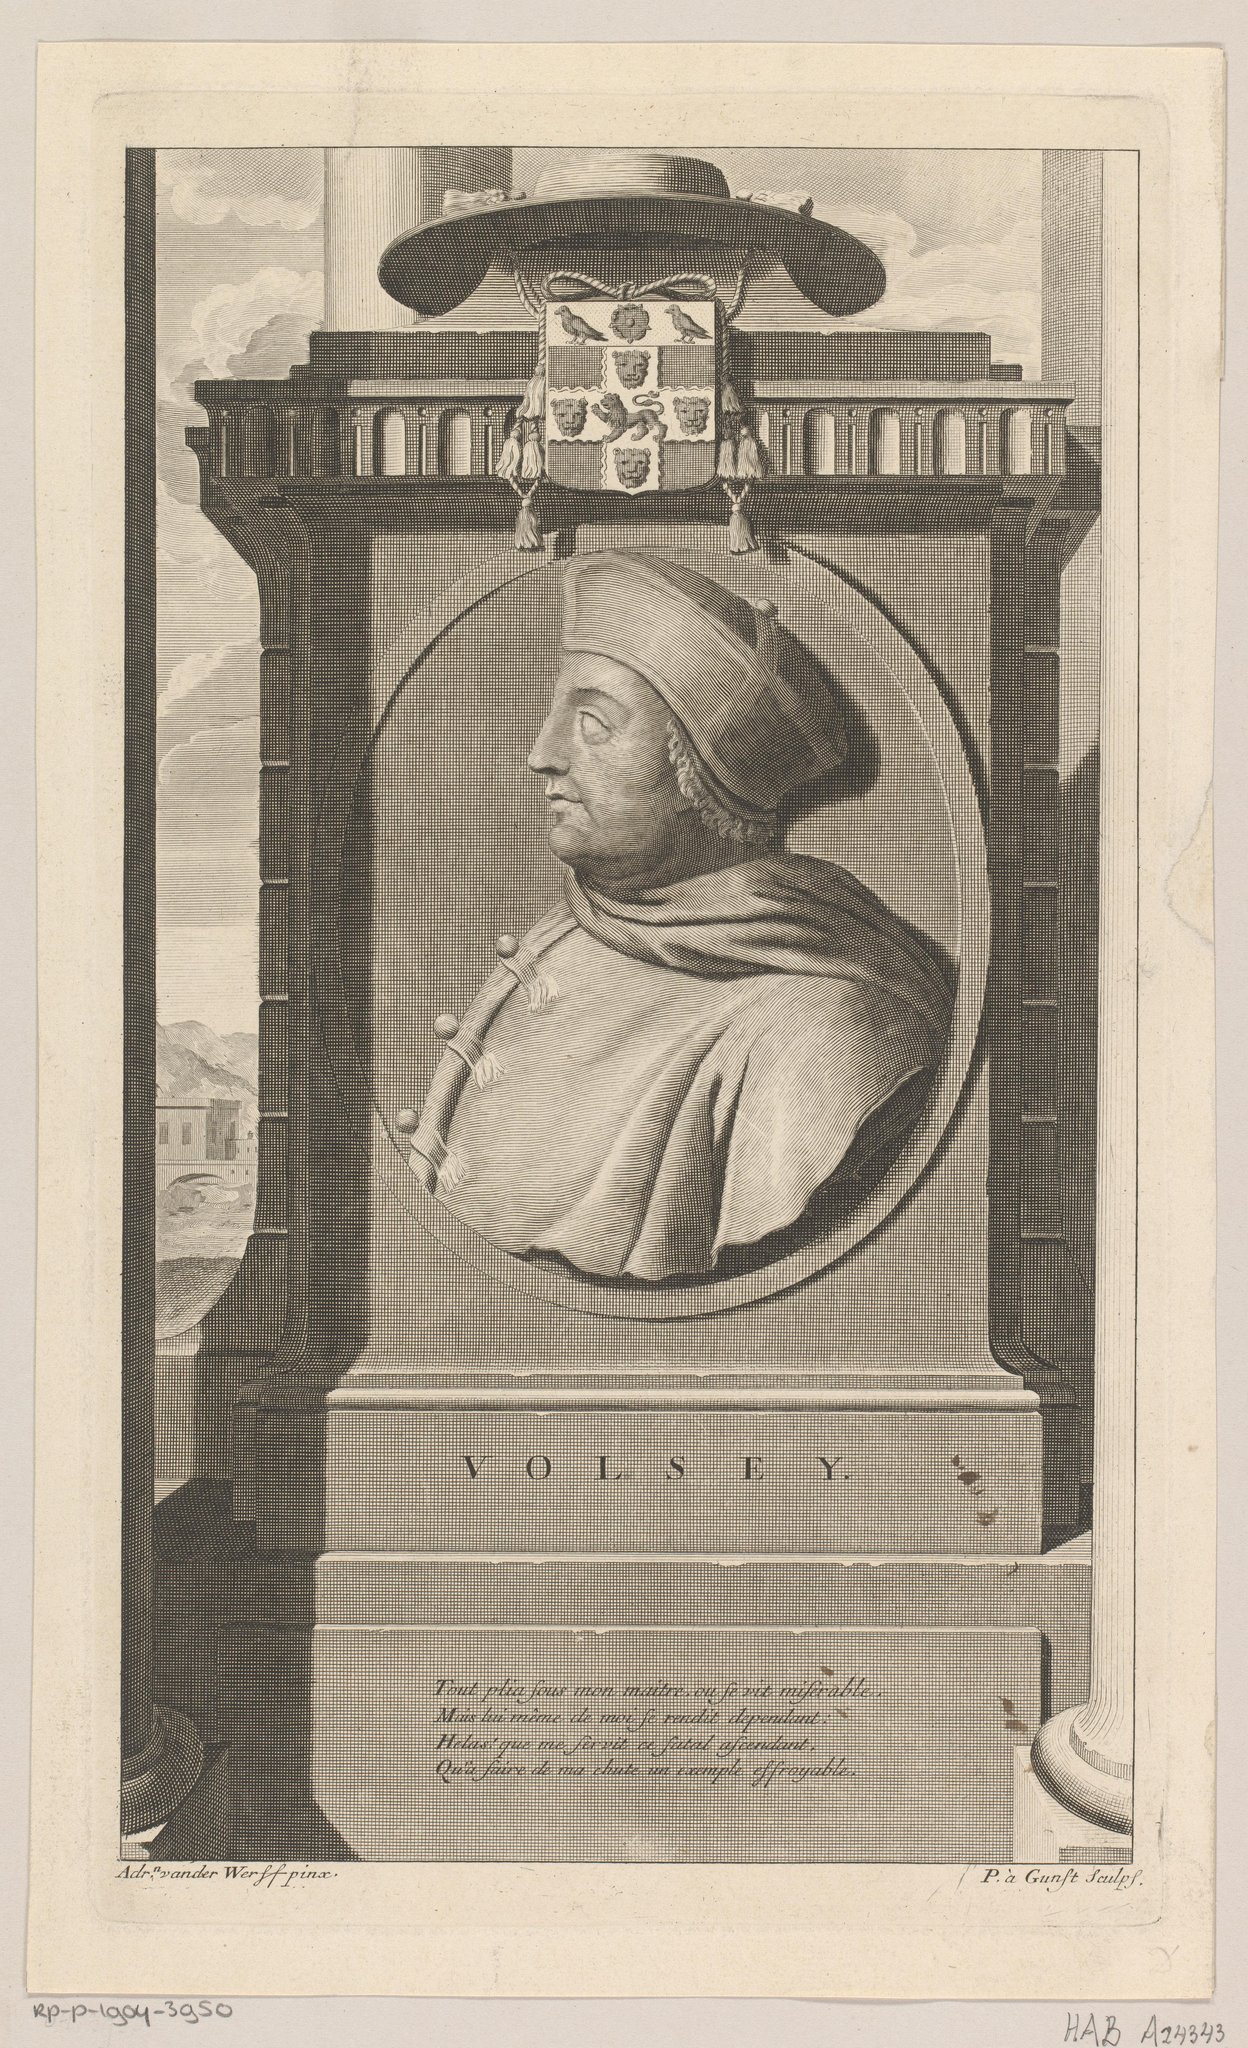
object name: print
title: Portret van Thomas Wolsey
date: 1697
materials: paper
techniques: engraving, etching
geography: rotterdam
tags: cardinal, historical persons, armorial bearing, heraldry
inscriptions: collector's mark: Lugt 2228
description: Prent uit: Larrey, Isaac de. Histoire d’Angleterre, d’Écosse, et d’Irlande (...). Rotterdam: Reinier Leers, 1697.